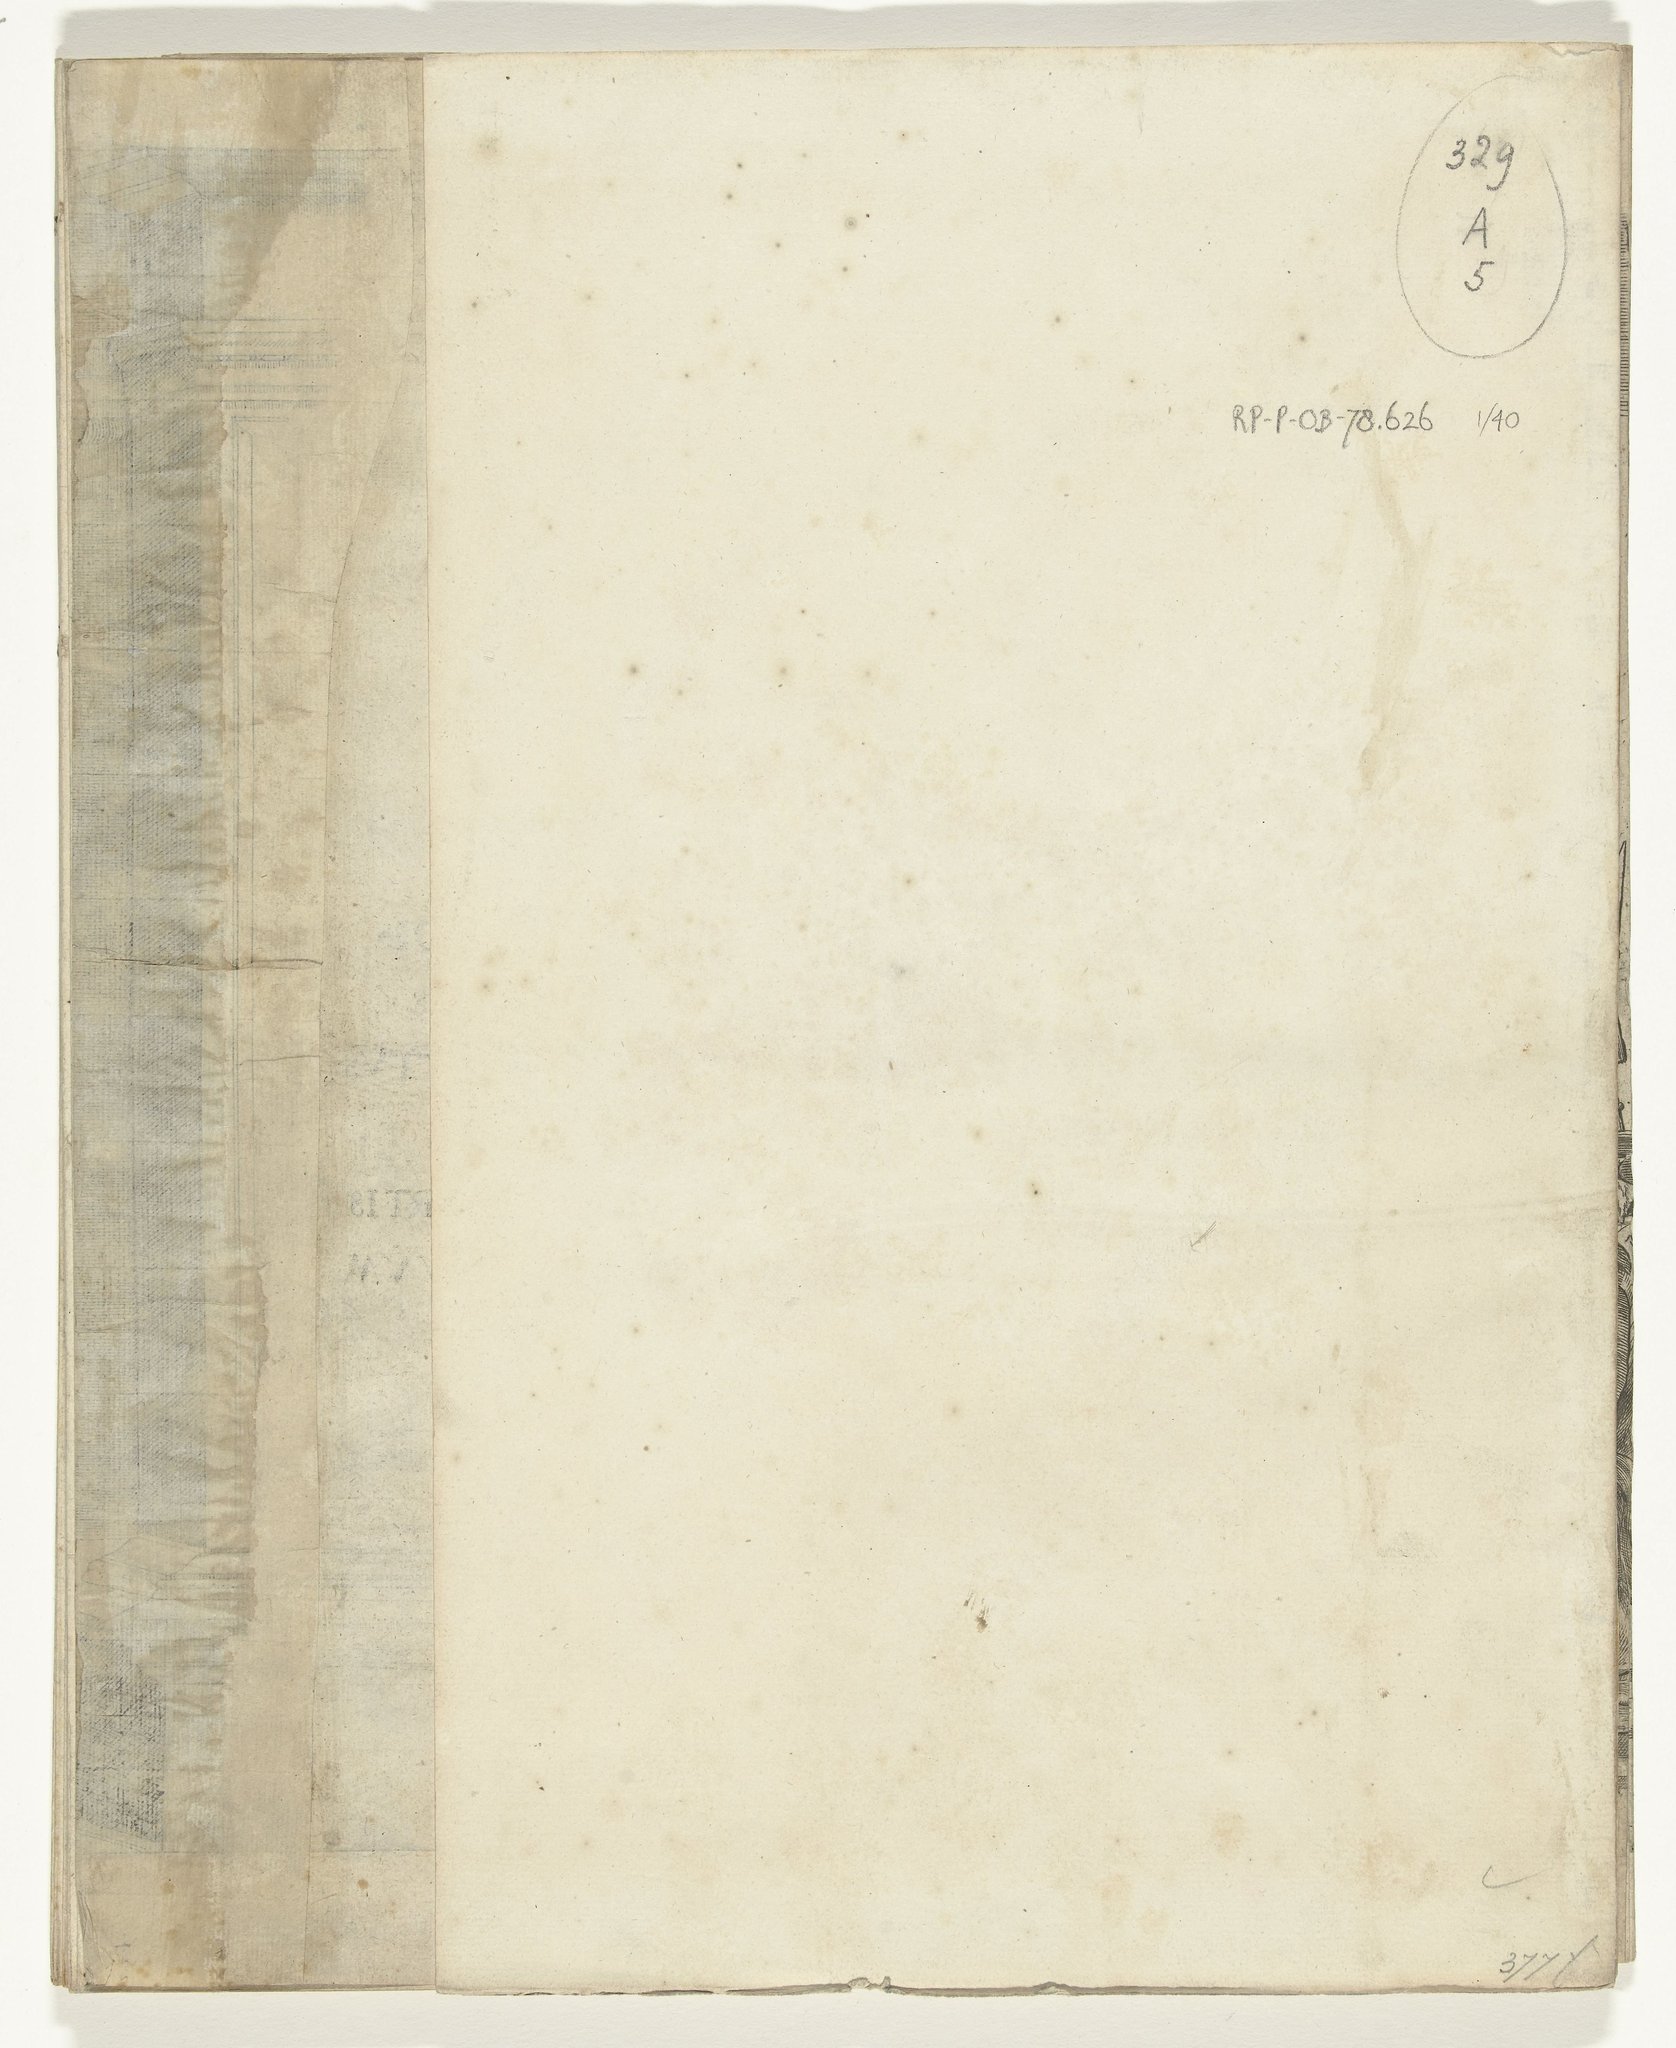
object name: prentrecueil, prentenalbum, prentalbum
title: Optocht van Karel V met de paus te Bologna na zijn kroning tot keizer, 1530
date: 1530-1536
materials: paper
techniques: engraving, etching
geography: mechelen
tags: ghent, charles v (holy roman emperor and king of spain), rome, festivities (+ parade, pageant, cavalcade ~ festive activities)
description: In plaats van de geneologische afstamming van Karel V in het huis van Oostenrijk is in deze uitgave bovenin de platen een nieuw lucht gegraveerd. De platen zijn genummerd 1-38. Deze uitgave is later dan die van Hondius. De platen zijn aanelkaar geplakt en vormen zo één lang (opgevouwen) fries. Het opgevouwen fries los in een map.